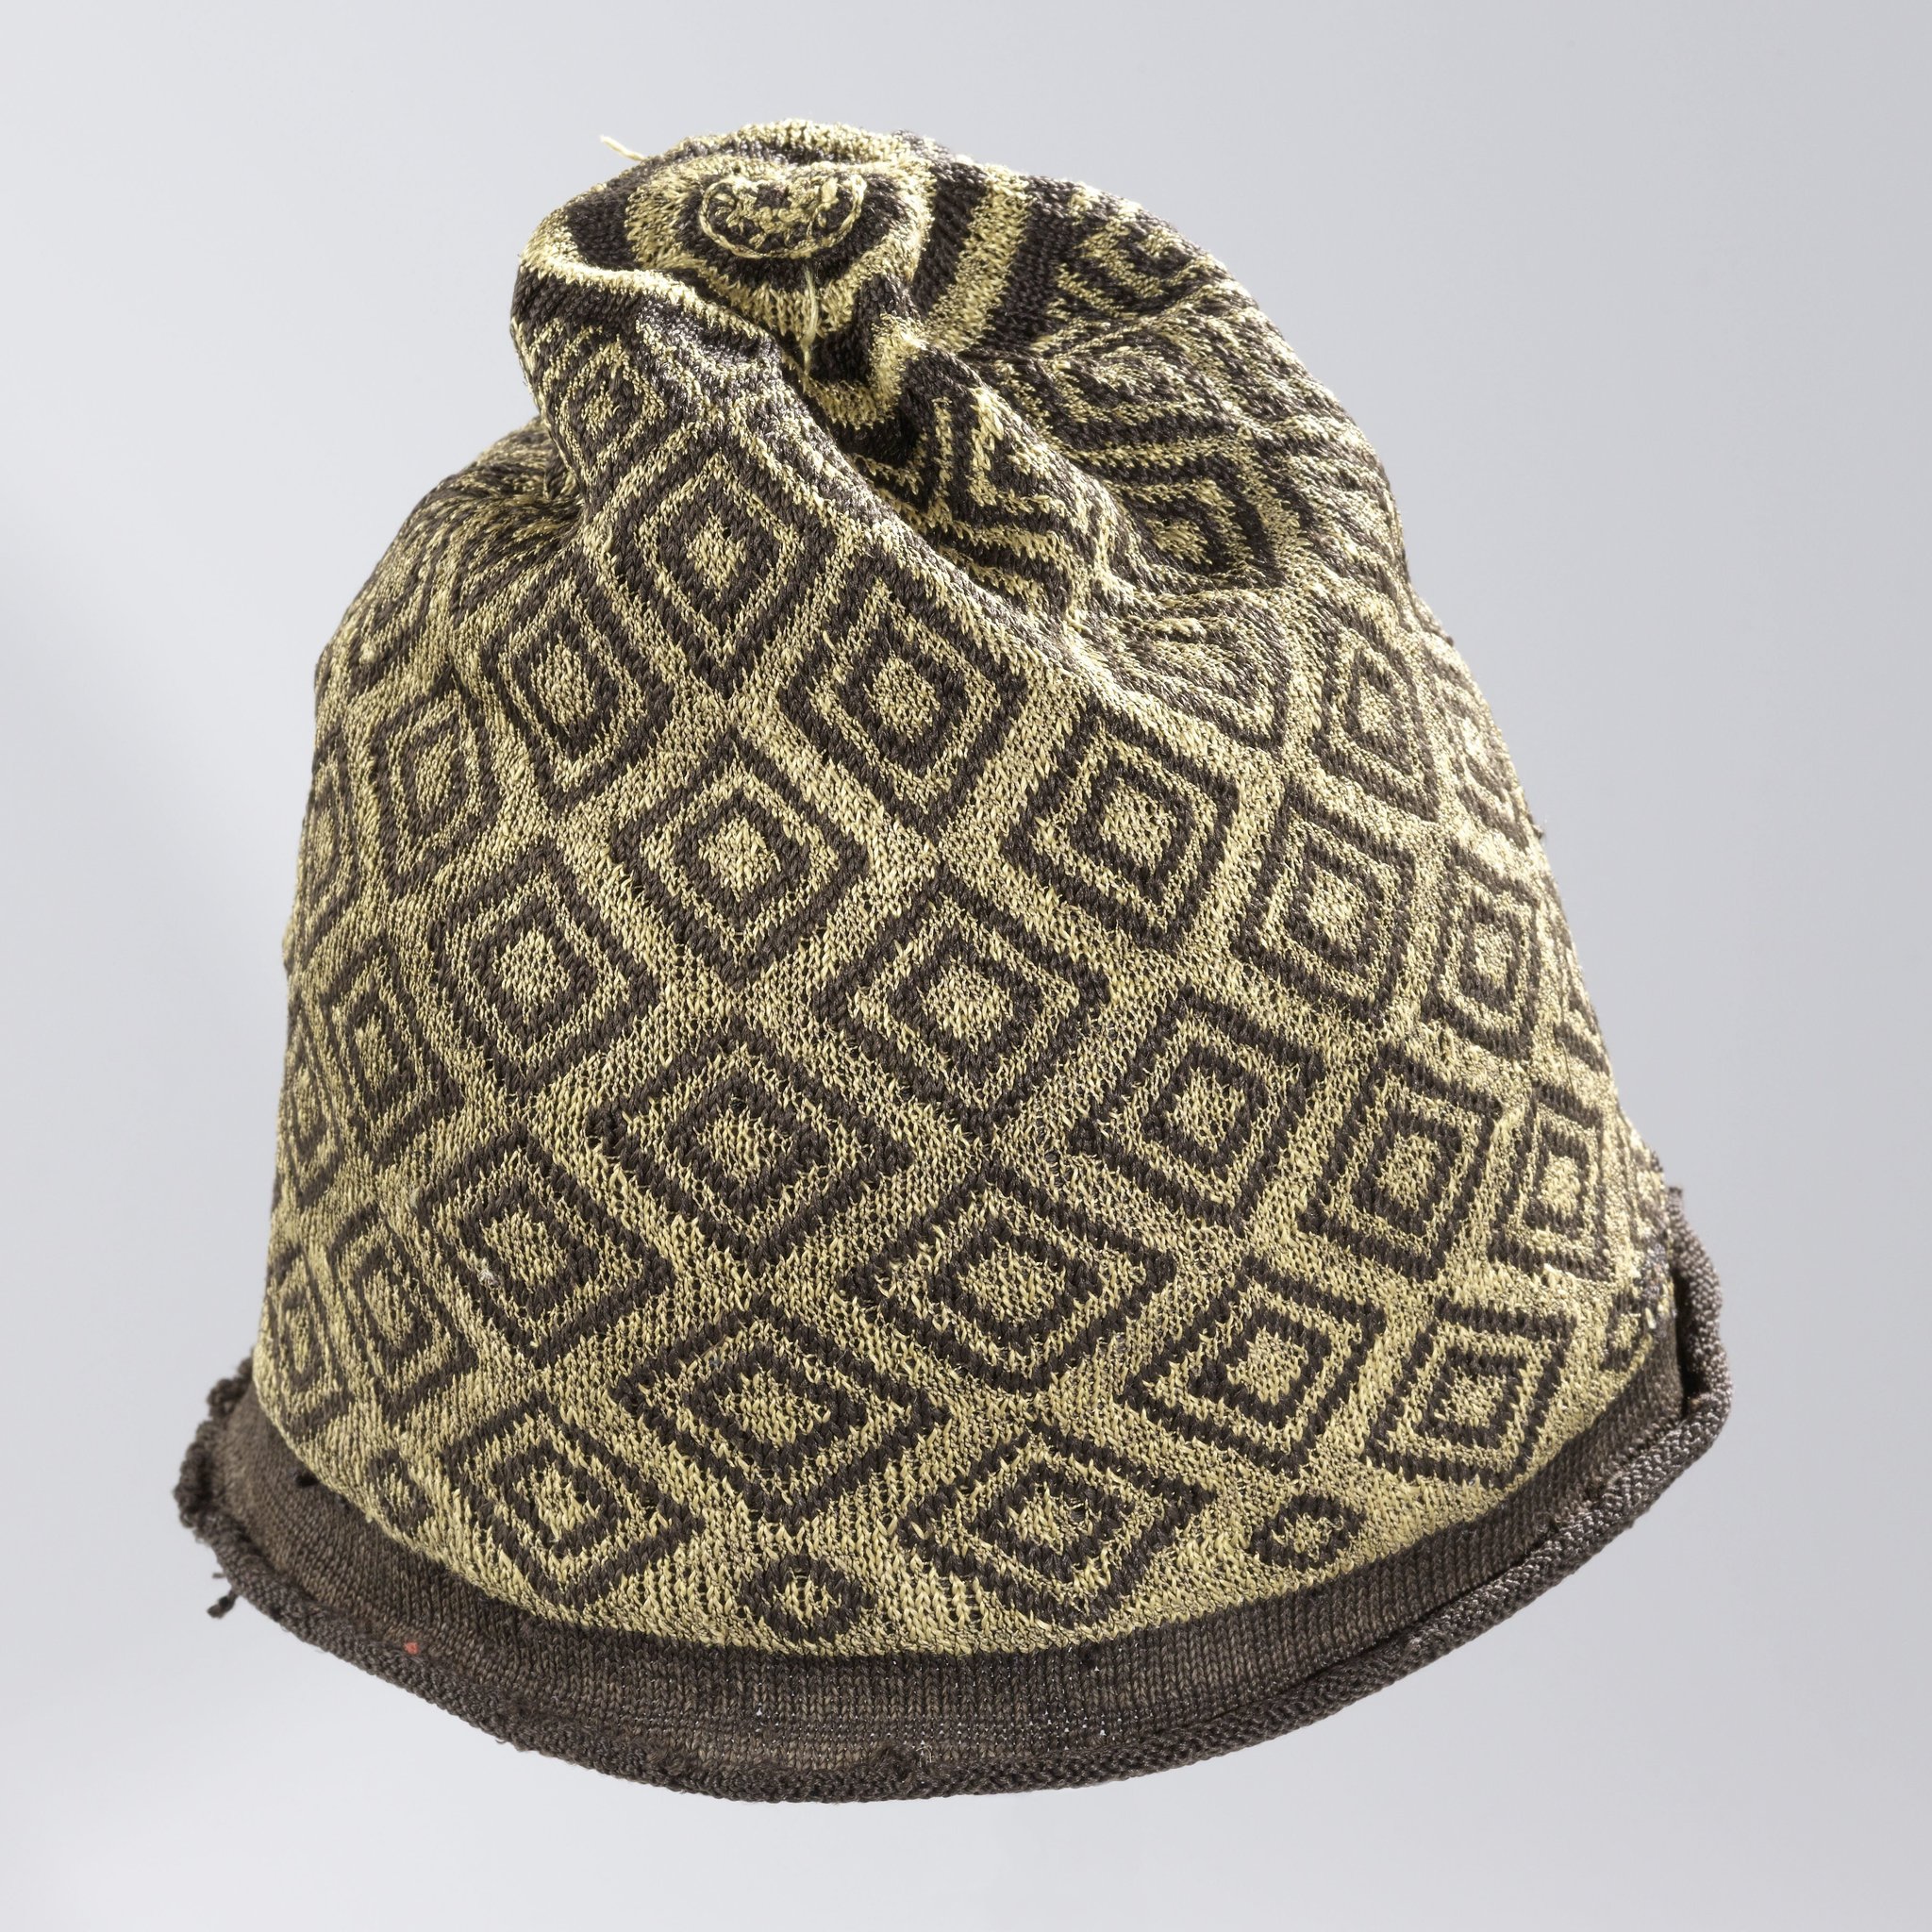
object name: huismuts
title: Muts, gebreid, bol van zwarte zijde met ruitvormige, geometrische ornamenten van gouddraad en een omgekrulde rand van effen zwarte zijde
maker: Anonymous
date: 1600-1699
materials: gold thread, silk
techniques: knitting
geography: monmouth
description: Muts, gebreid, bol van zwarte zijde met ruitvormige, geometrische ornamenten van gouddraad en een rand van effen zwarte zijde. Rond gebreid met vier of vijf naalden. Het gouddraad is meegebreid met de zwarte zijde. Middenachter een 'naad', waar geminderd is. Geheel rechts gebreid. De versiering bevindt zich op de bol, de omgekrulde 'rand' is effen. De muts is hoogstwaarschijnlijk in vorm gebracht door stomen en oprekken, aangezien er haast niet gemeerderd of geminderd is om de vorm te bereiken.